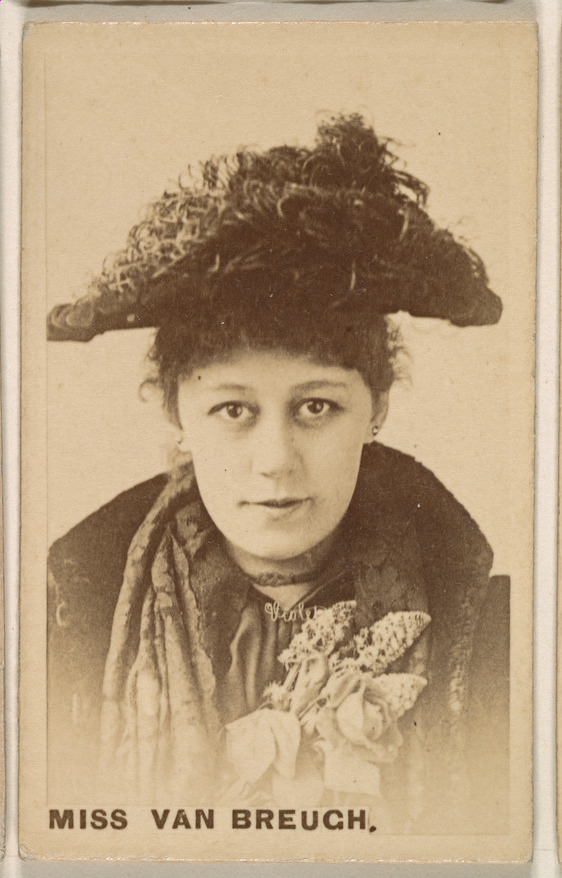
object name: photograph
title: Miss Van Breugh, from the Actresses series (N246), Type 1, issued by Kinney Brothers to promote Sporting Extra Cigarettes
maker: kinney brothers tobacco company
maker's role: publisher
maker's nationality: american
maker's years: 1869-2011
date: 1890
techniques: albumen silver print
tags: portraits,women,actresses